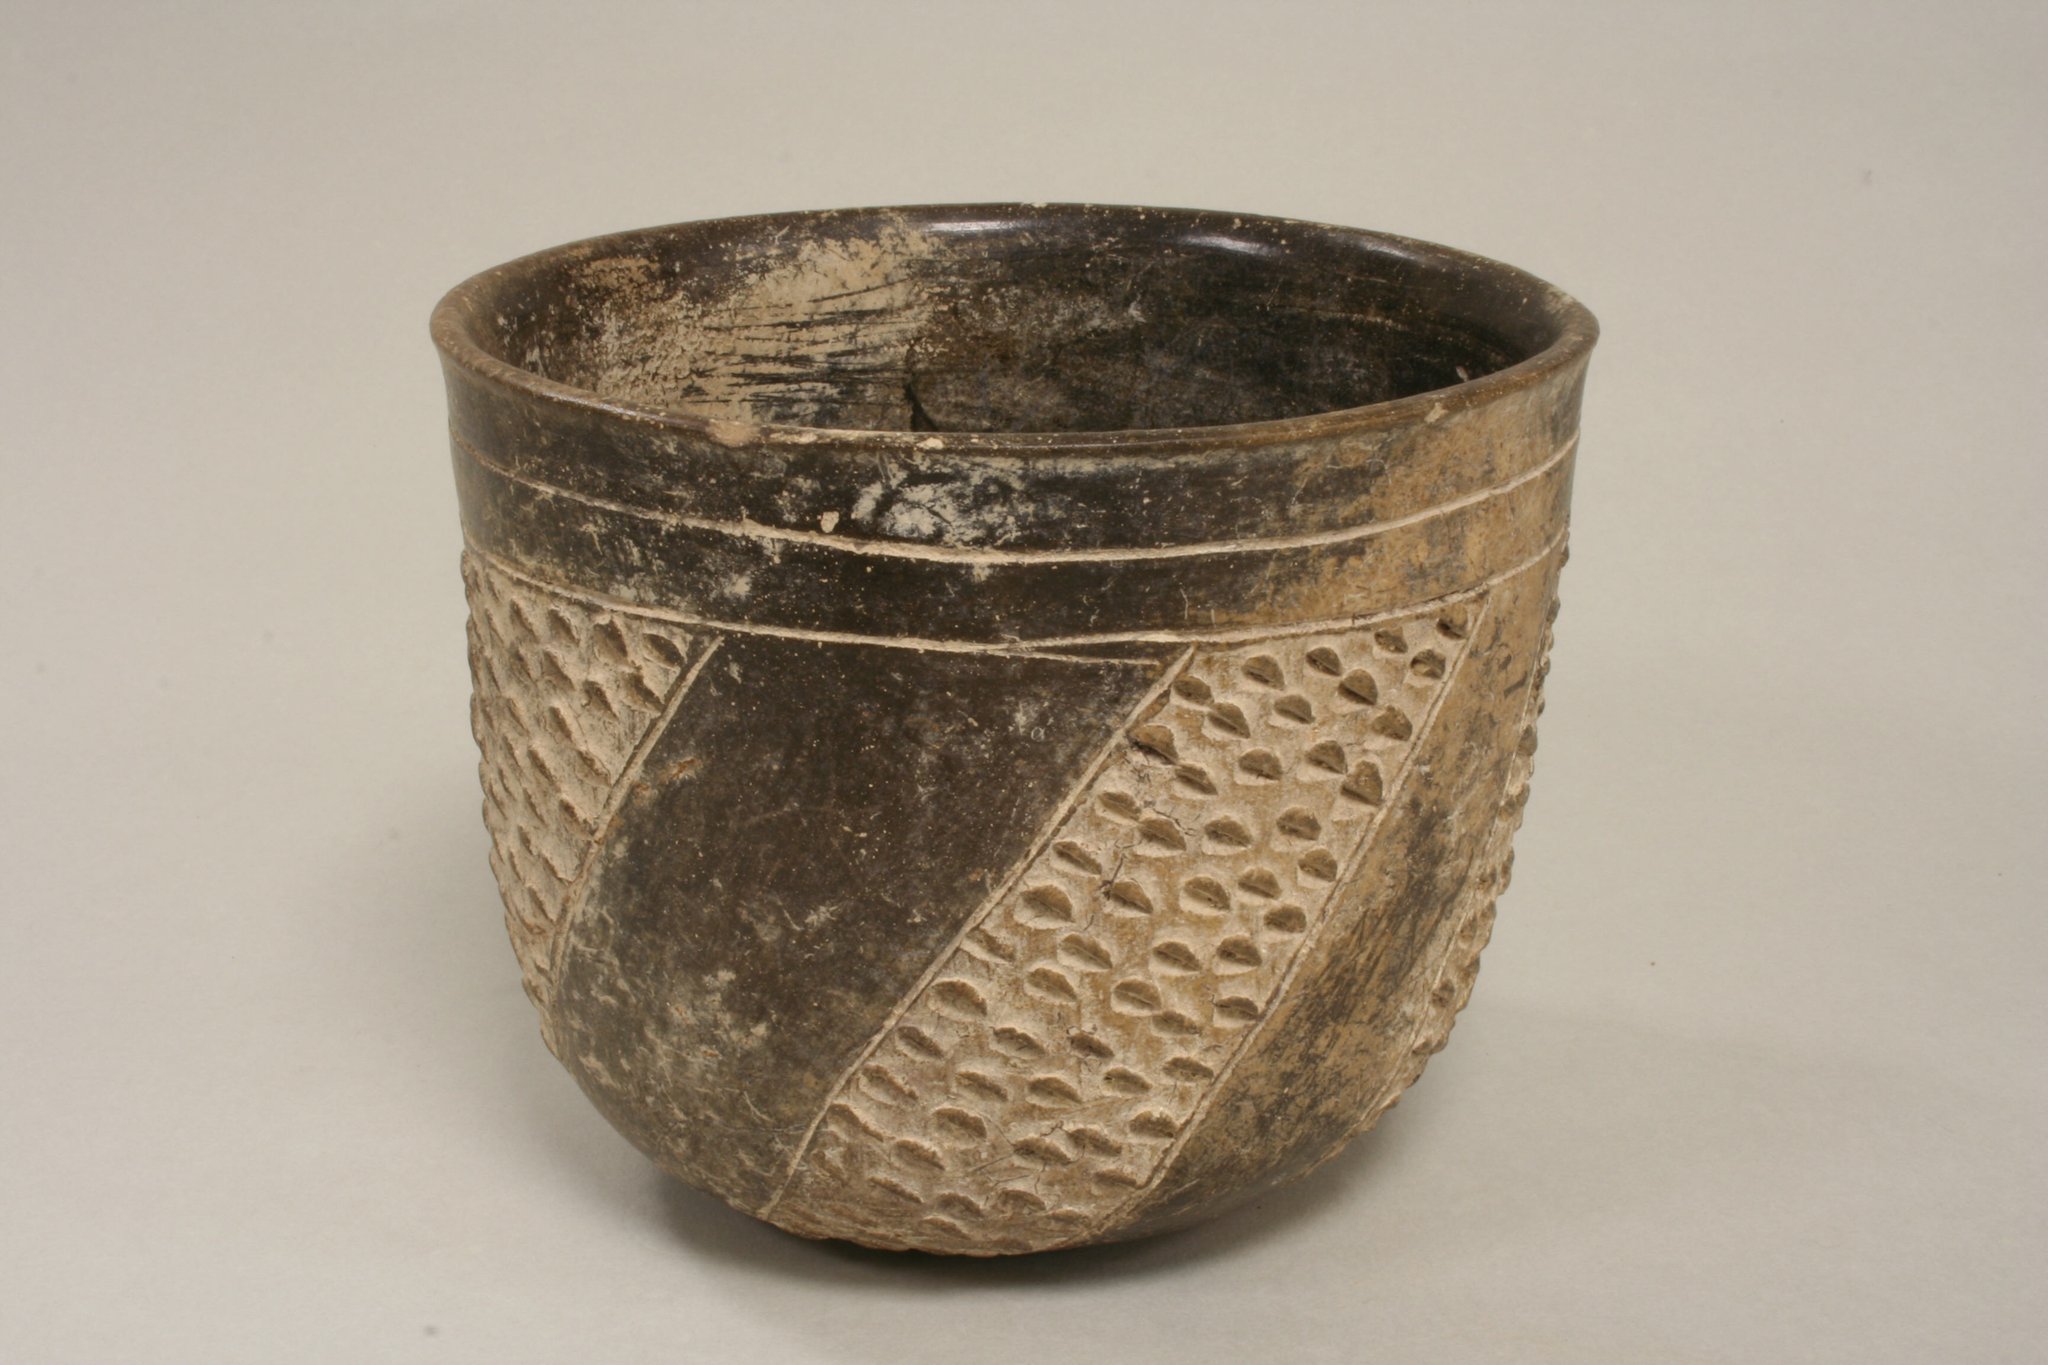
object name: bowl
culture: veracruz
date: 900-101 BCE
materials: ceramic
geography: mexico